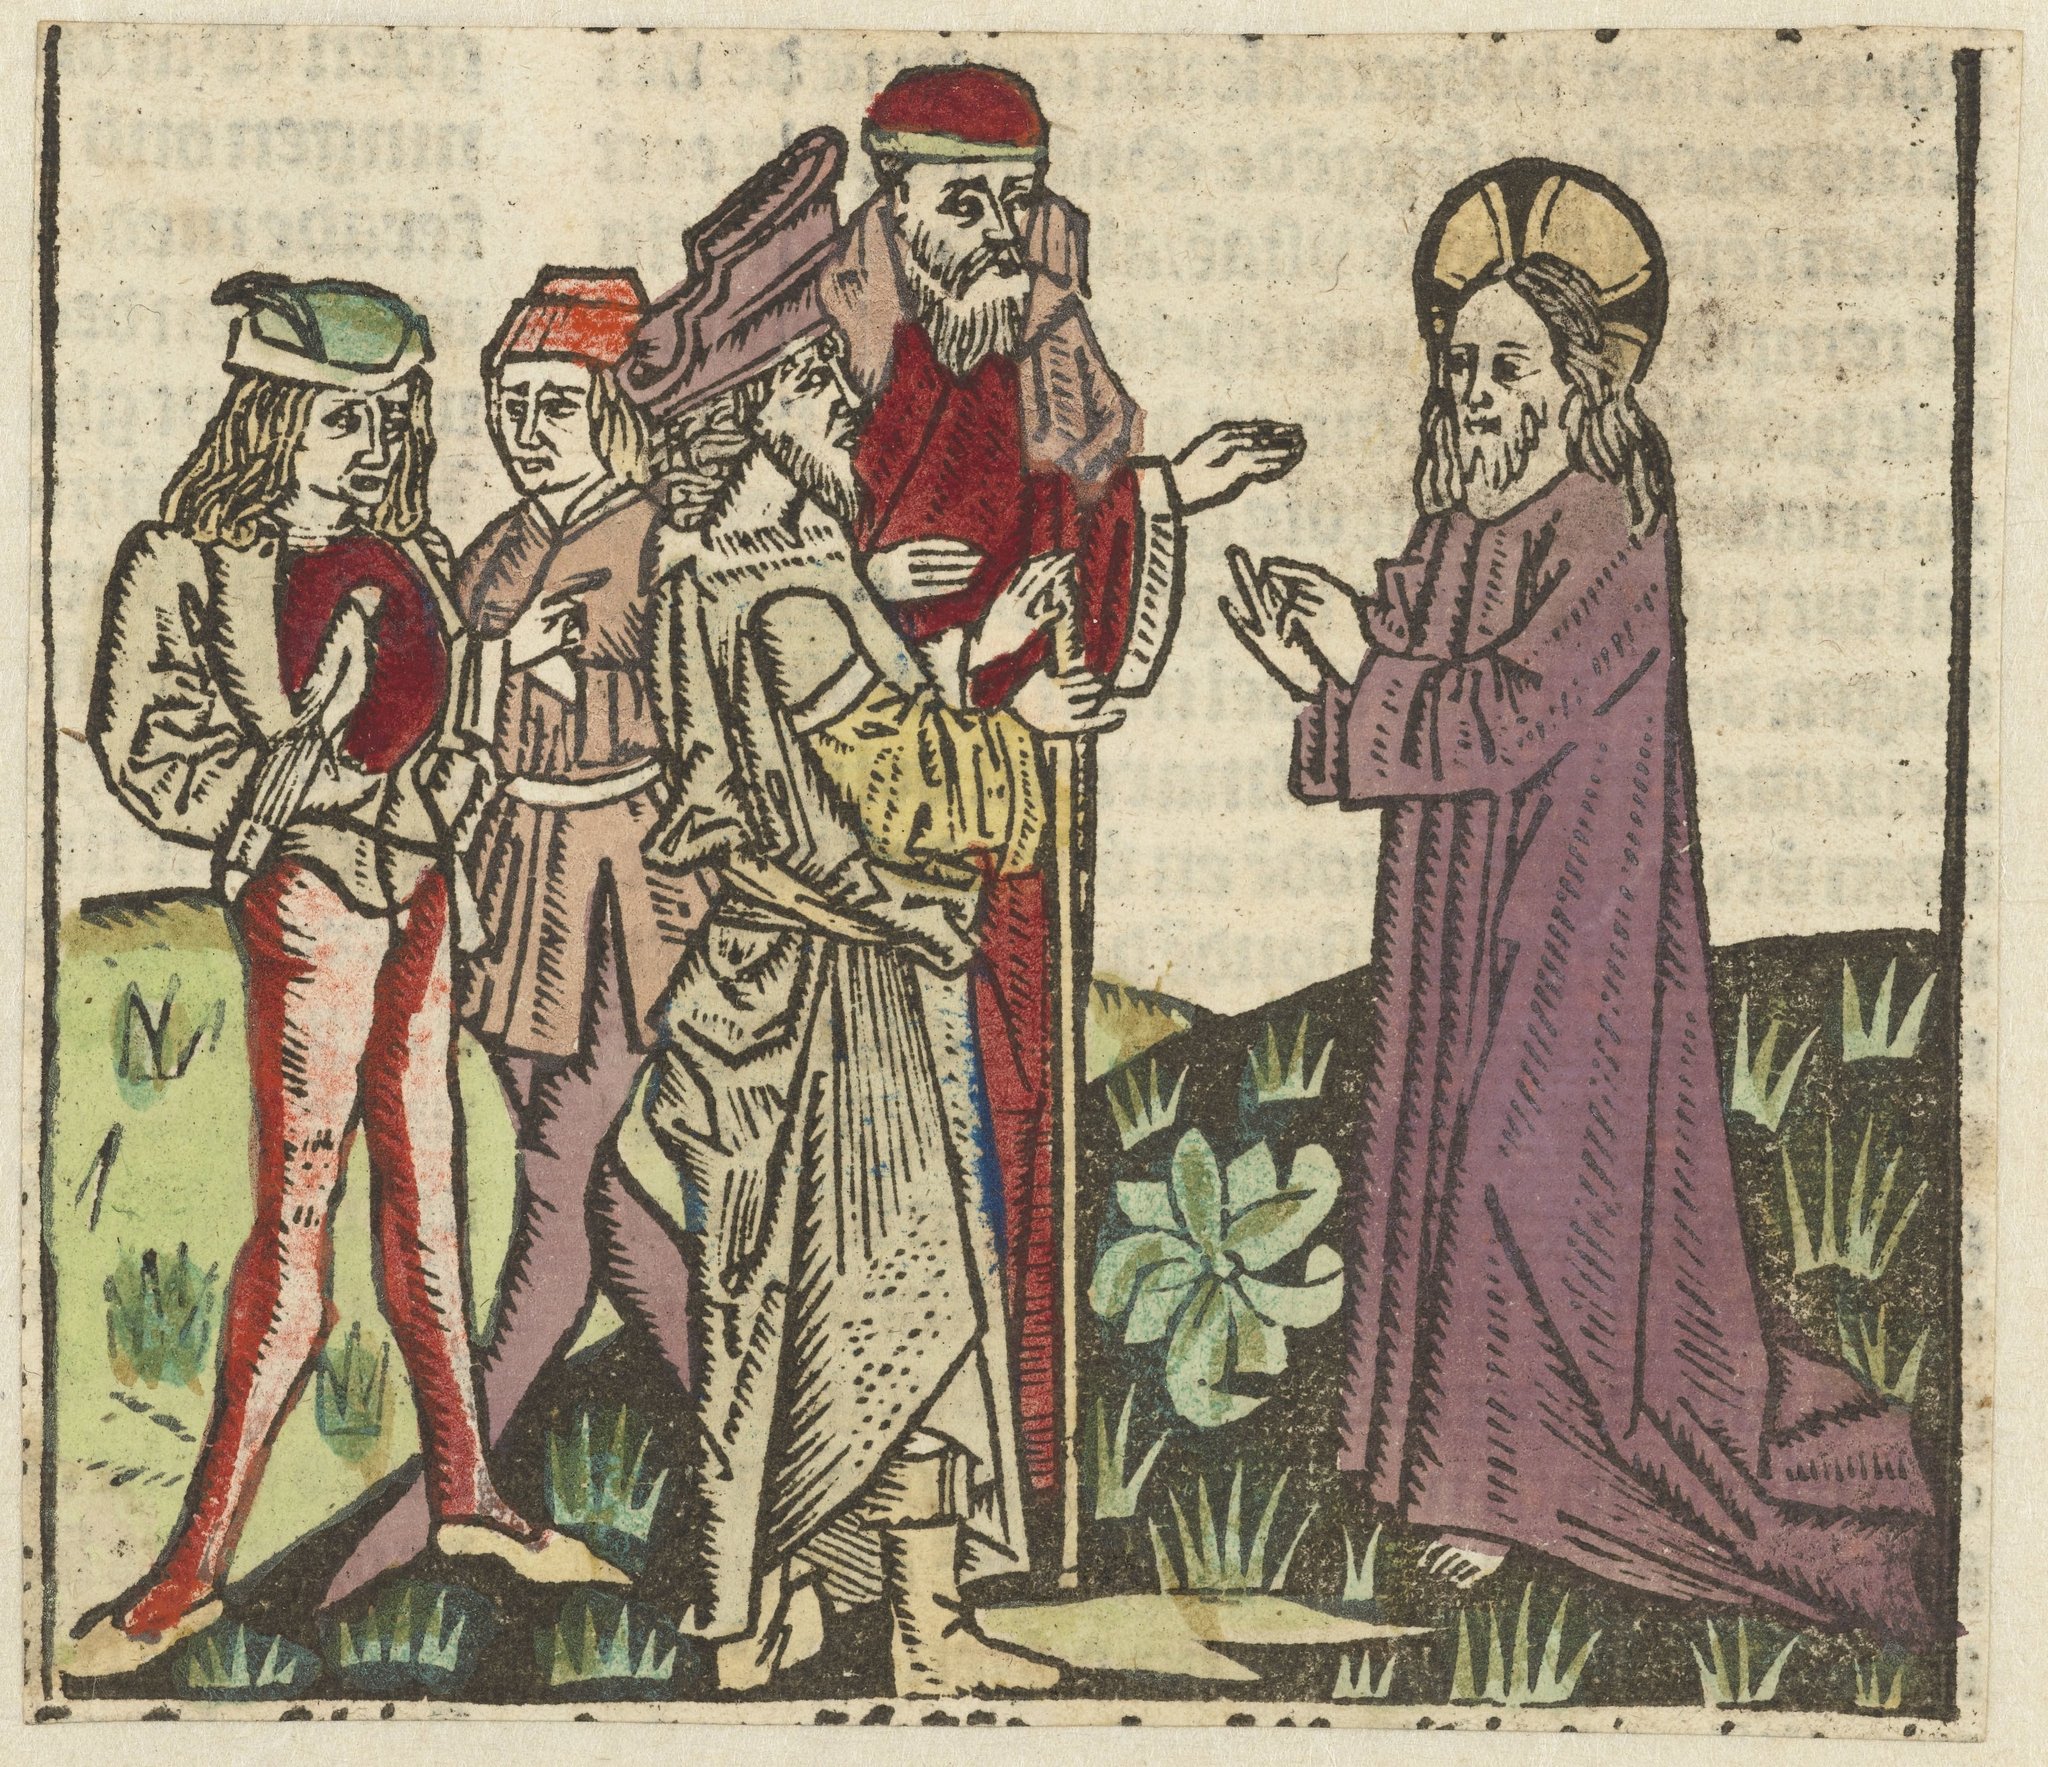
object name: book illustration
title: Christus in gesprek met Nicodemus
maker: the first antwerp woodcutter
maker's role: print maker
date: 1485-1491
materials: paper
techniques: hand coloring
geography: low countries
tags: christ talking with nicodemus at night (john 3:1-21)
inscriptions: collector's mark: Lugt 2228a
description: Eén van 46 houtsnedes uit Ludolphus de Saxonia "Tboeck vandan leven ons heeren Jesu Christi", een anonieme Nederlandse vertaling. Deze versie van het werk van Ludolphus bevat houtsneden van de Meester van Gouda (II), de Meester van Antwerpen (I) en de Meester van Haarlem. Botke, K. Boek van Ludolphus is voor het eerst uitgegeven in 1487 door Geeraert Leeu te Antwerpen. In 1488 uitgegeven door Claes Leeu te Antwerpen, in 1495 en 1499 en 1519 door Peter van Os te Zwolle en in 1510 door A. van Berghen te Antwerpen. Deze 46 houtsneden komen waarschijnlijk uit een uitgave van Peter van Os. Botke, K. Oorspronkelijke blok voor deze prent was groter. Zie "De gulden passer" (1951), cat.nr. 27.